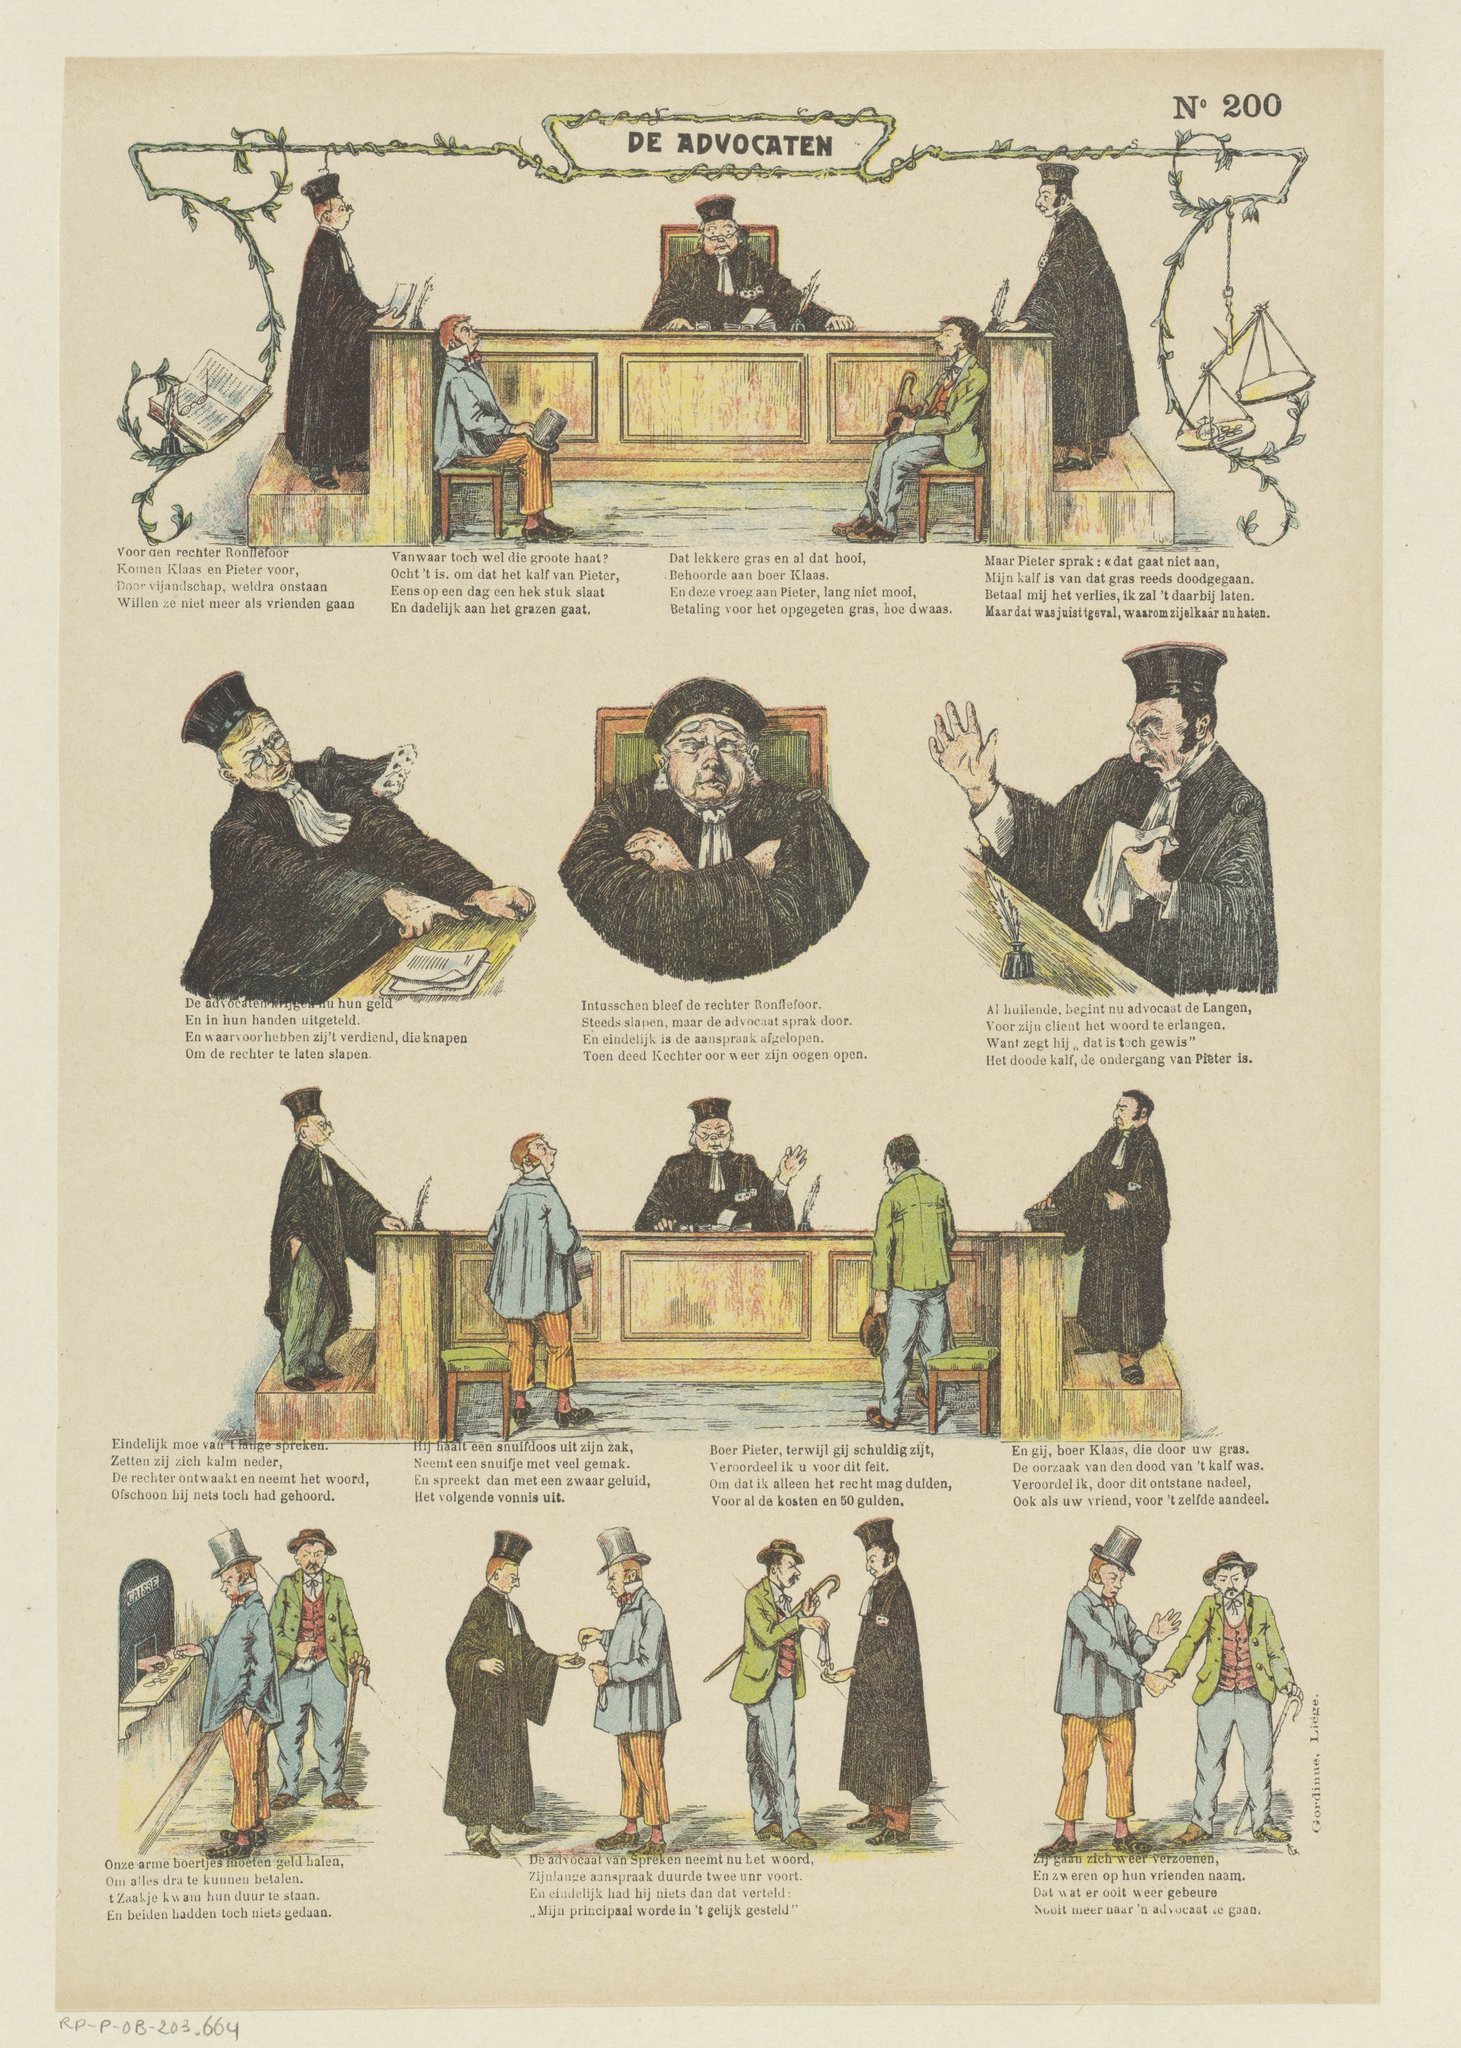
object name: popular print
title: De advocaten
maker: monogrammist jgr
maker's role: print maker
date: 1894-1959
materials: paper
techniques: lithograph, letterpress printing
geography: liège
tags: lawyer, attorney at law, court session (court of justice)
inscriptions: collector's mark: Lugt 2760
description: Blad met 8 voorstellingen over twee vrienden die elkaar voor de rechter slepen. Onder elke afbeelding een onderschrift. Genummerd rechtsboven: No 200.